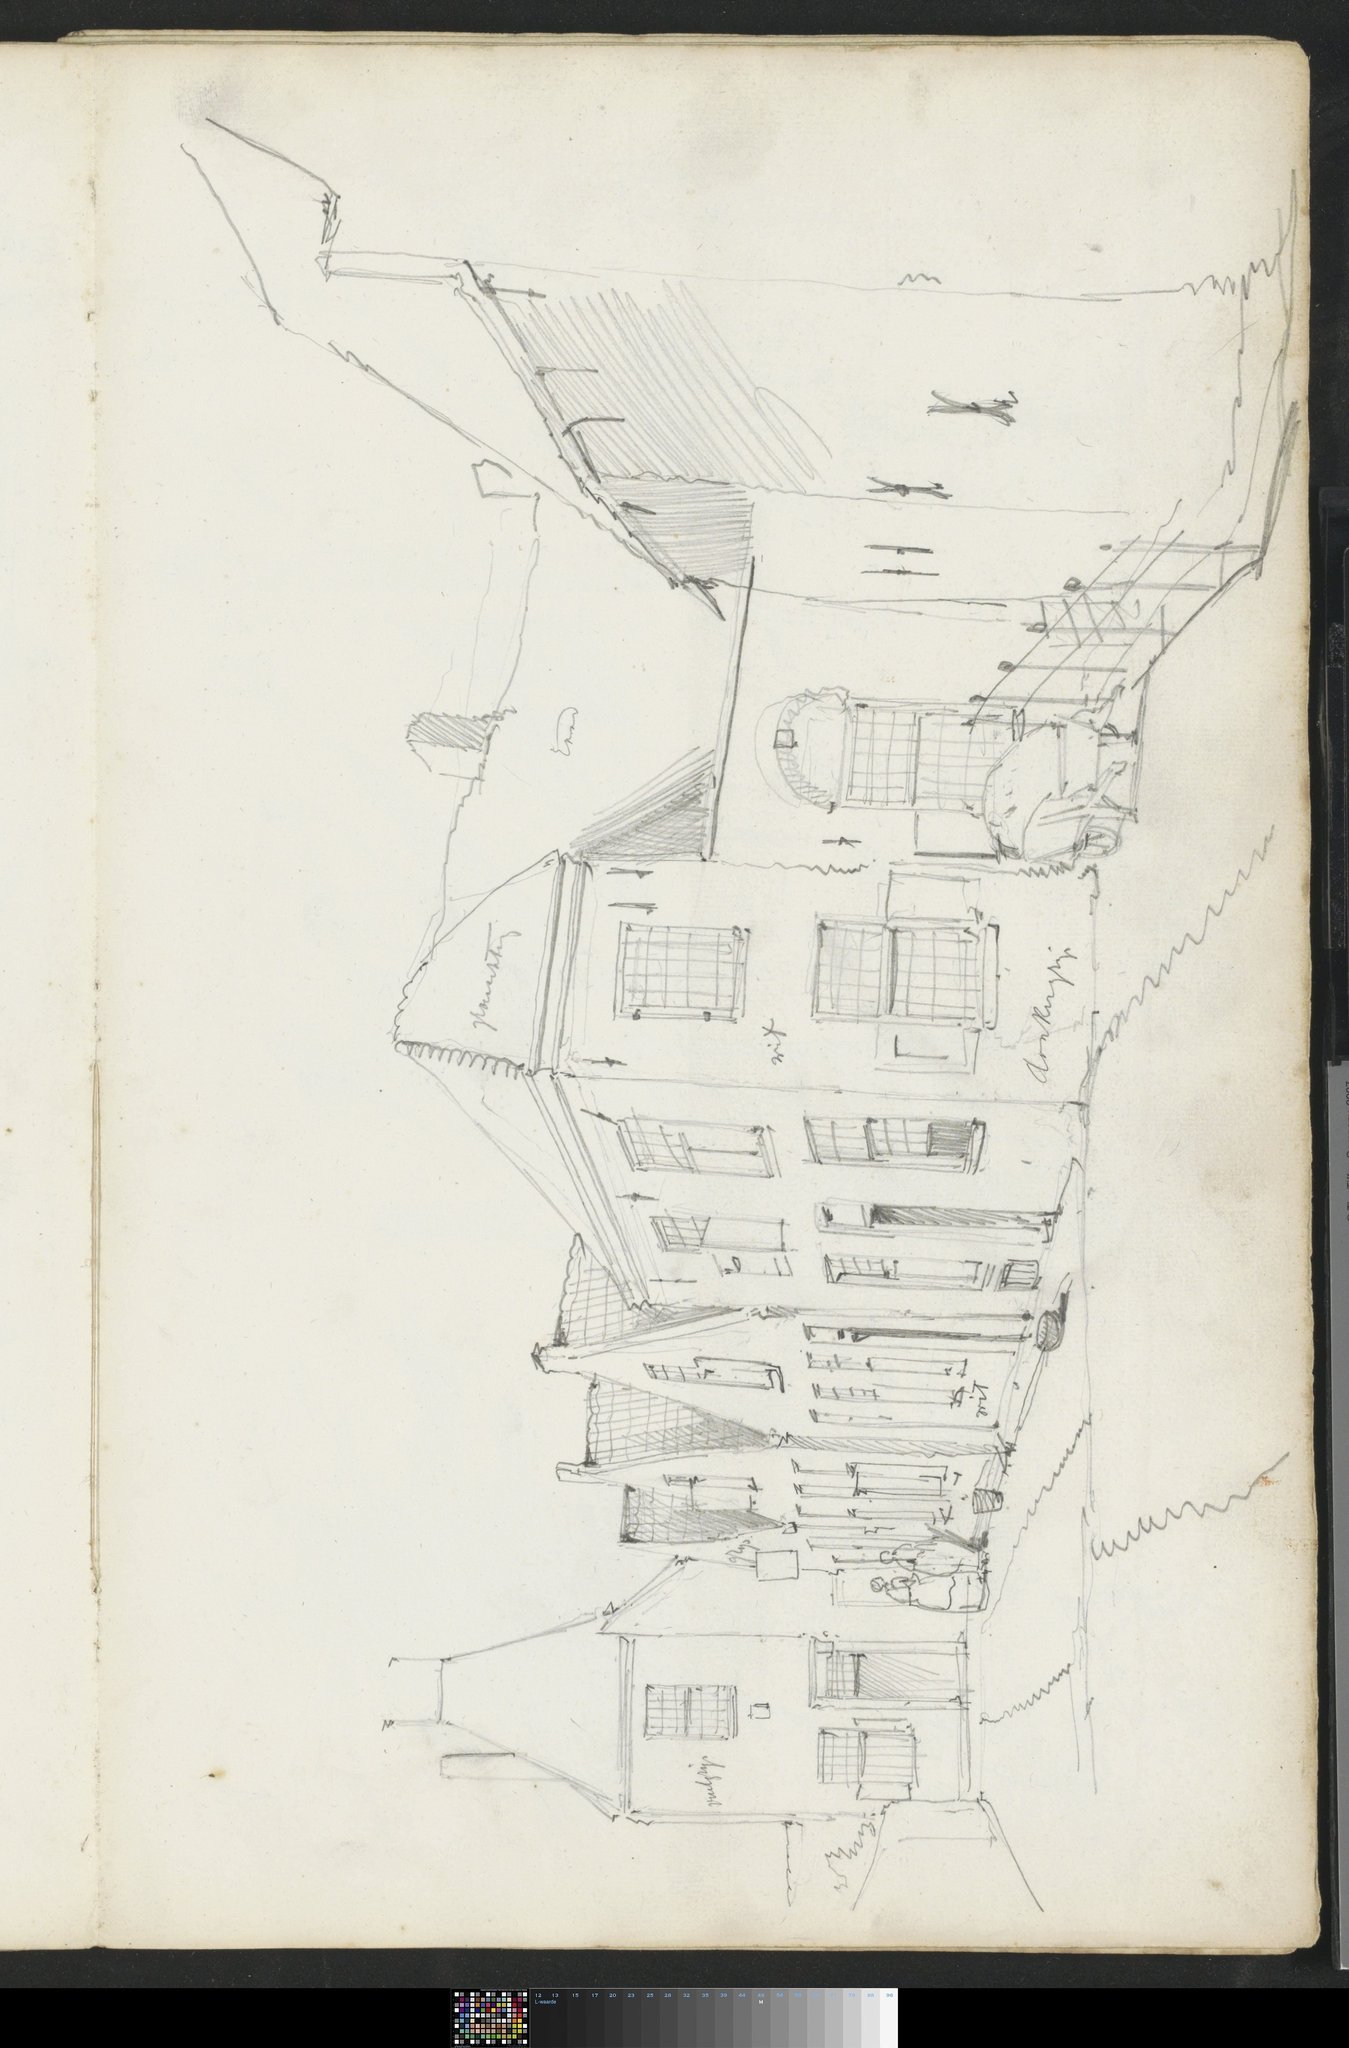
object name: sketchbook leaf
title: Straatgezicht met figuren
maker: willem koekkoek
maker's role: draughtsman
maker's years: 1839-1895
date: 1849-1895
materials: paper, pencil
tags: city-view, and landscape with man-made constructions (+ city(-scape) with figures, staffage)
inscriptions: kleurnotitie, handgeschreven in potlood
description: Blad 23 recto uit een schetsboek met 42 bladen.